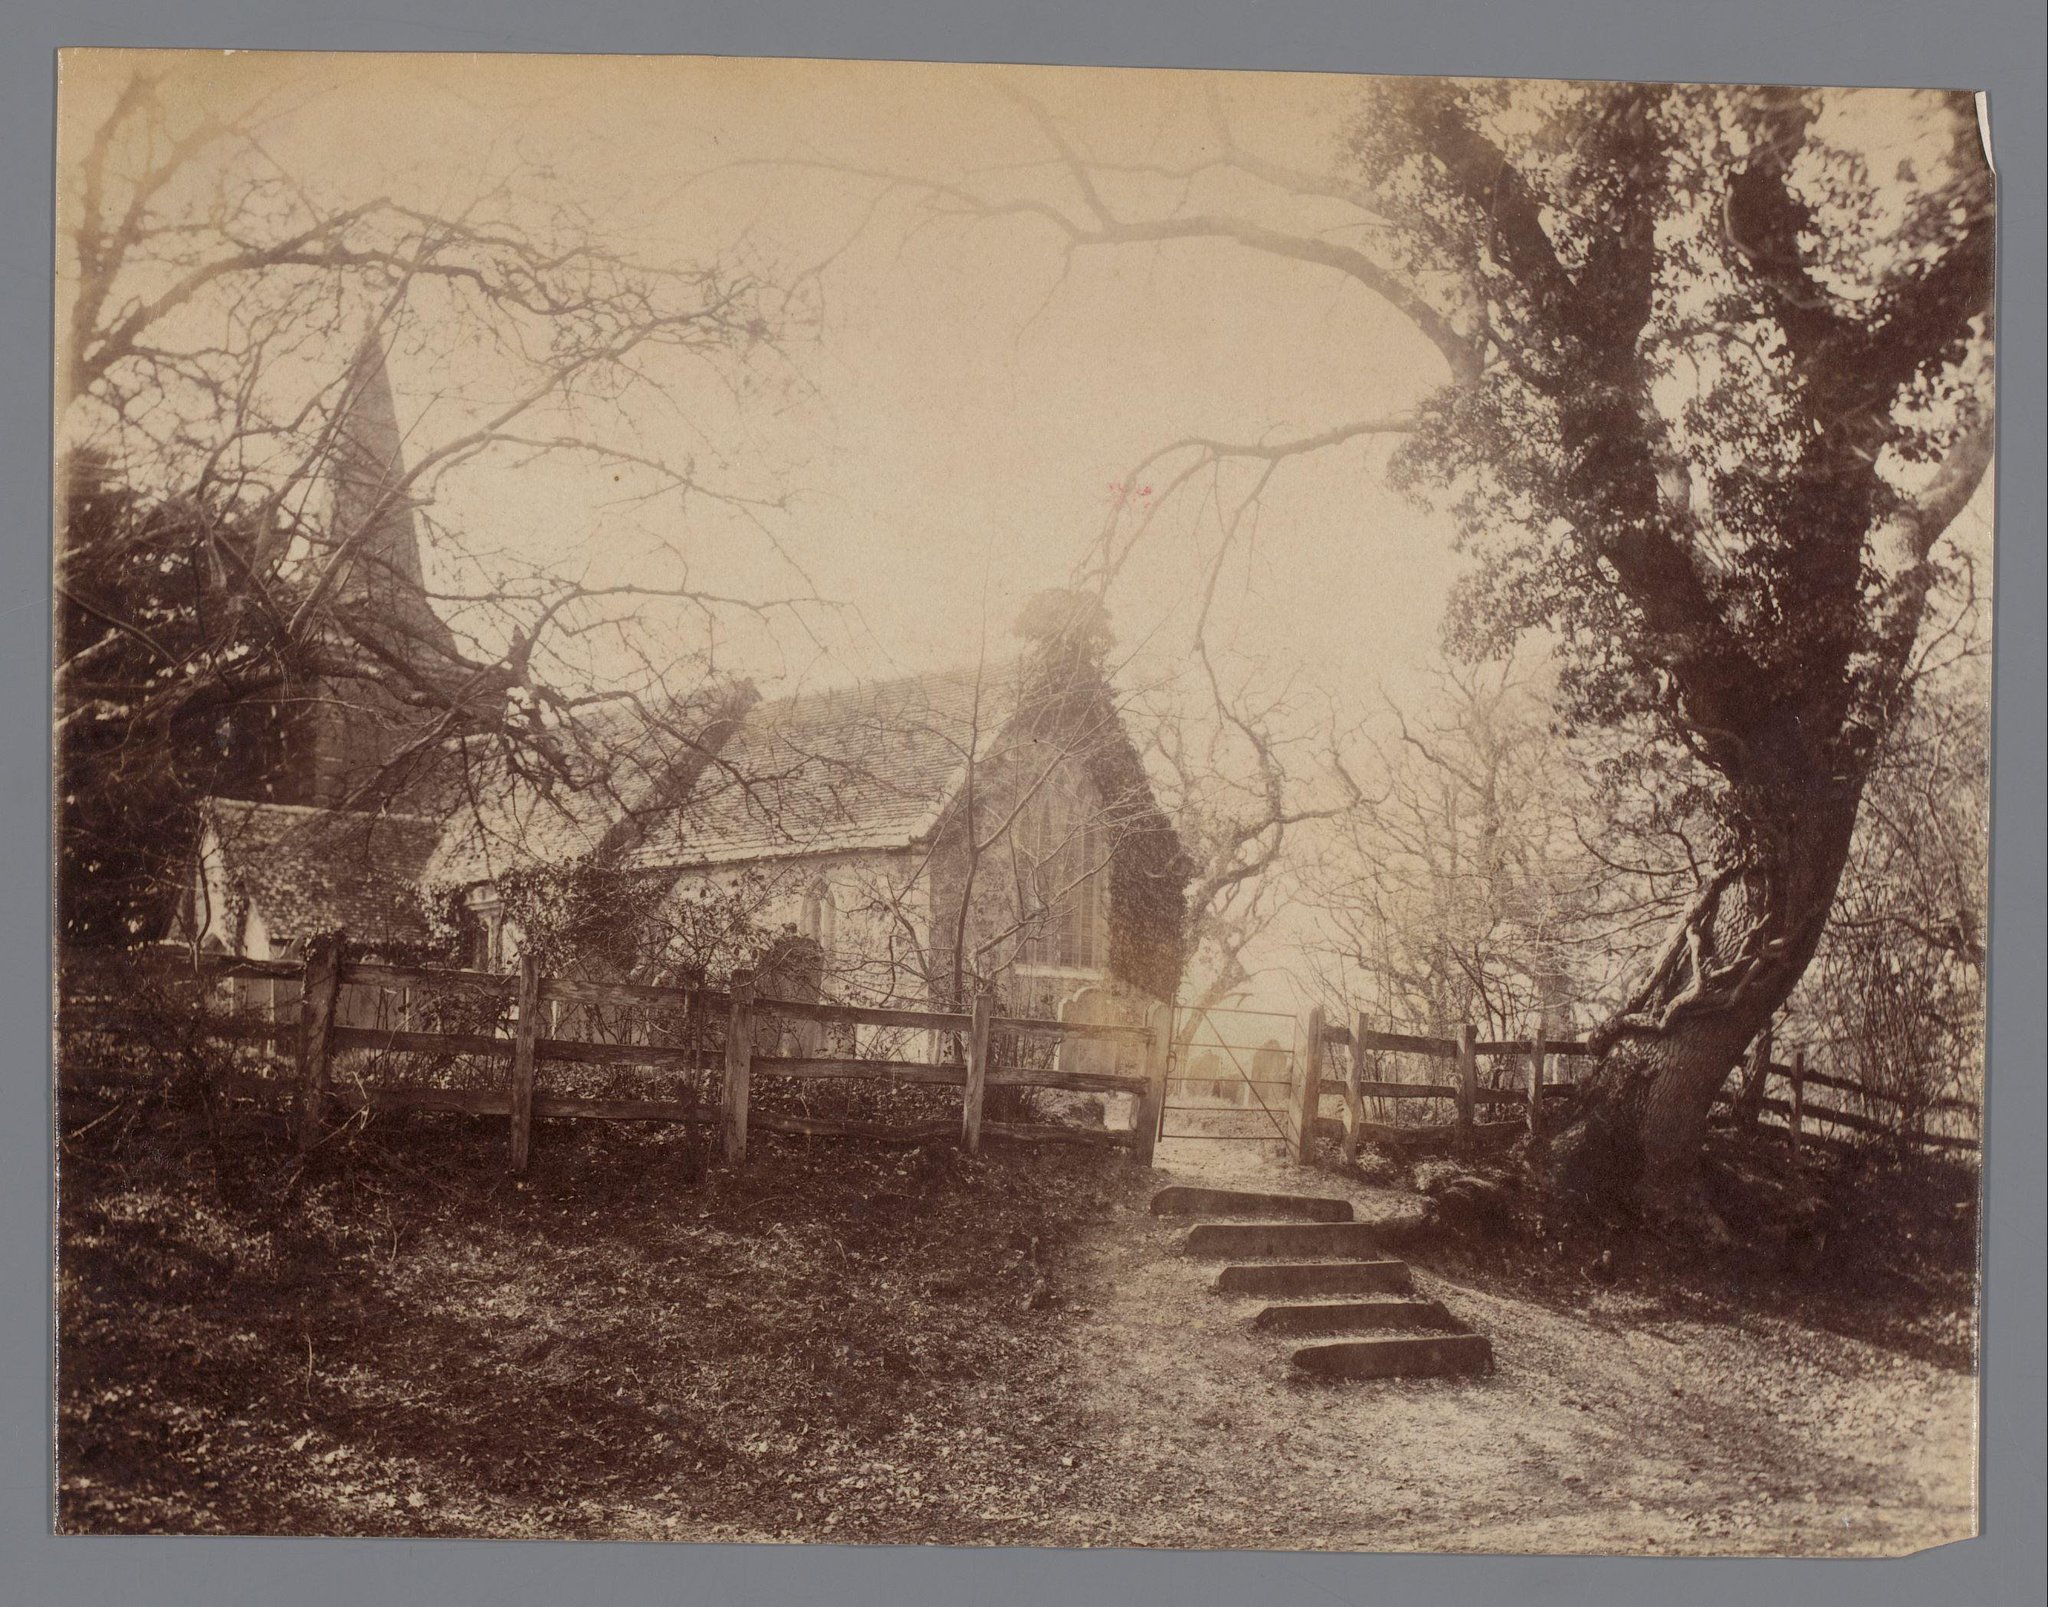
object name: photograph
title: Kerk in in bosrijk landschap ("Brokenhand Old Church")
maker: Anonymous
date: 1870-1890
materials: paper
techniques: albumen print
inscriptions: inscription: ‘Brokenhand Old Church’, inscription: ‘M.U [?] + nu/nee [?]’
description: Kerk in in bosrijk landschap ("Brokenhand Old Church").